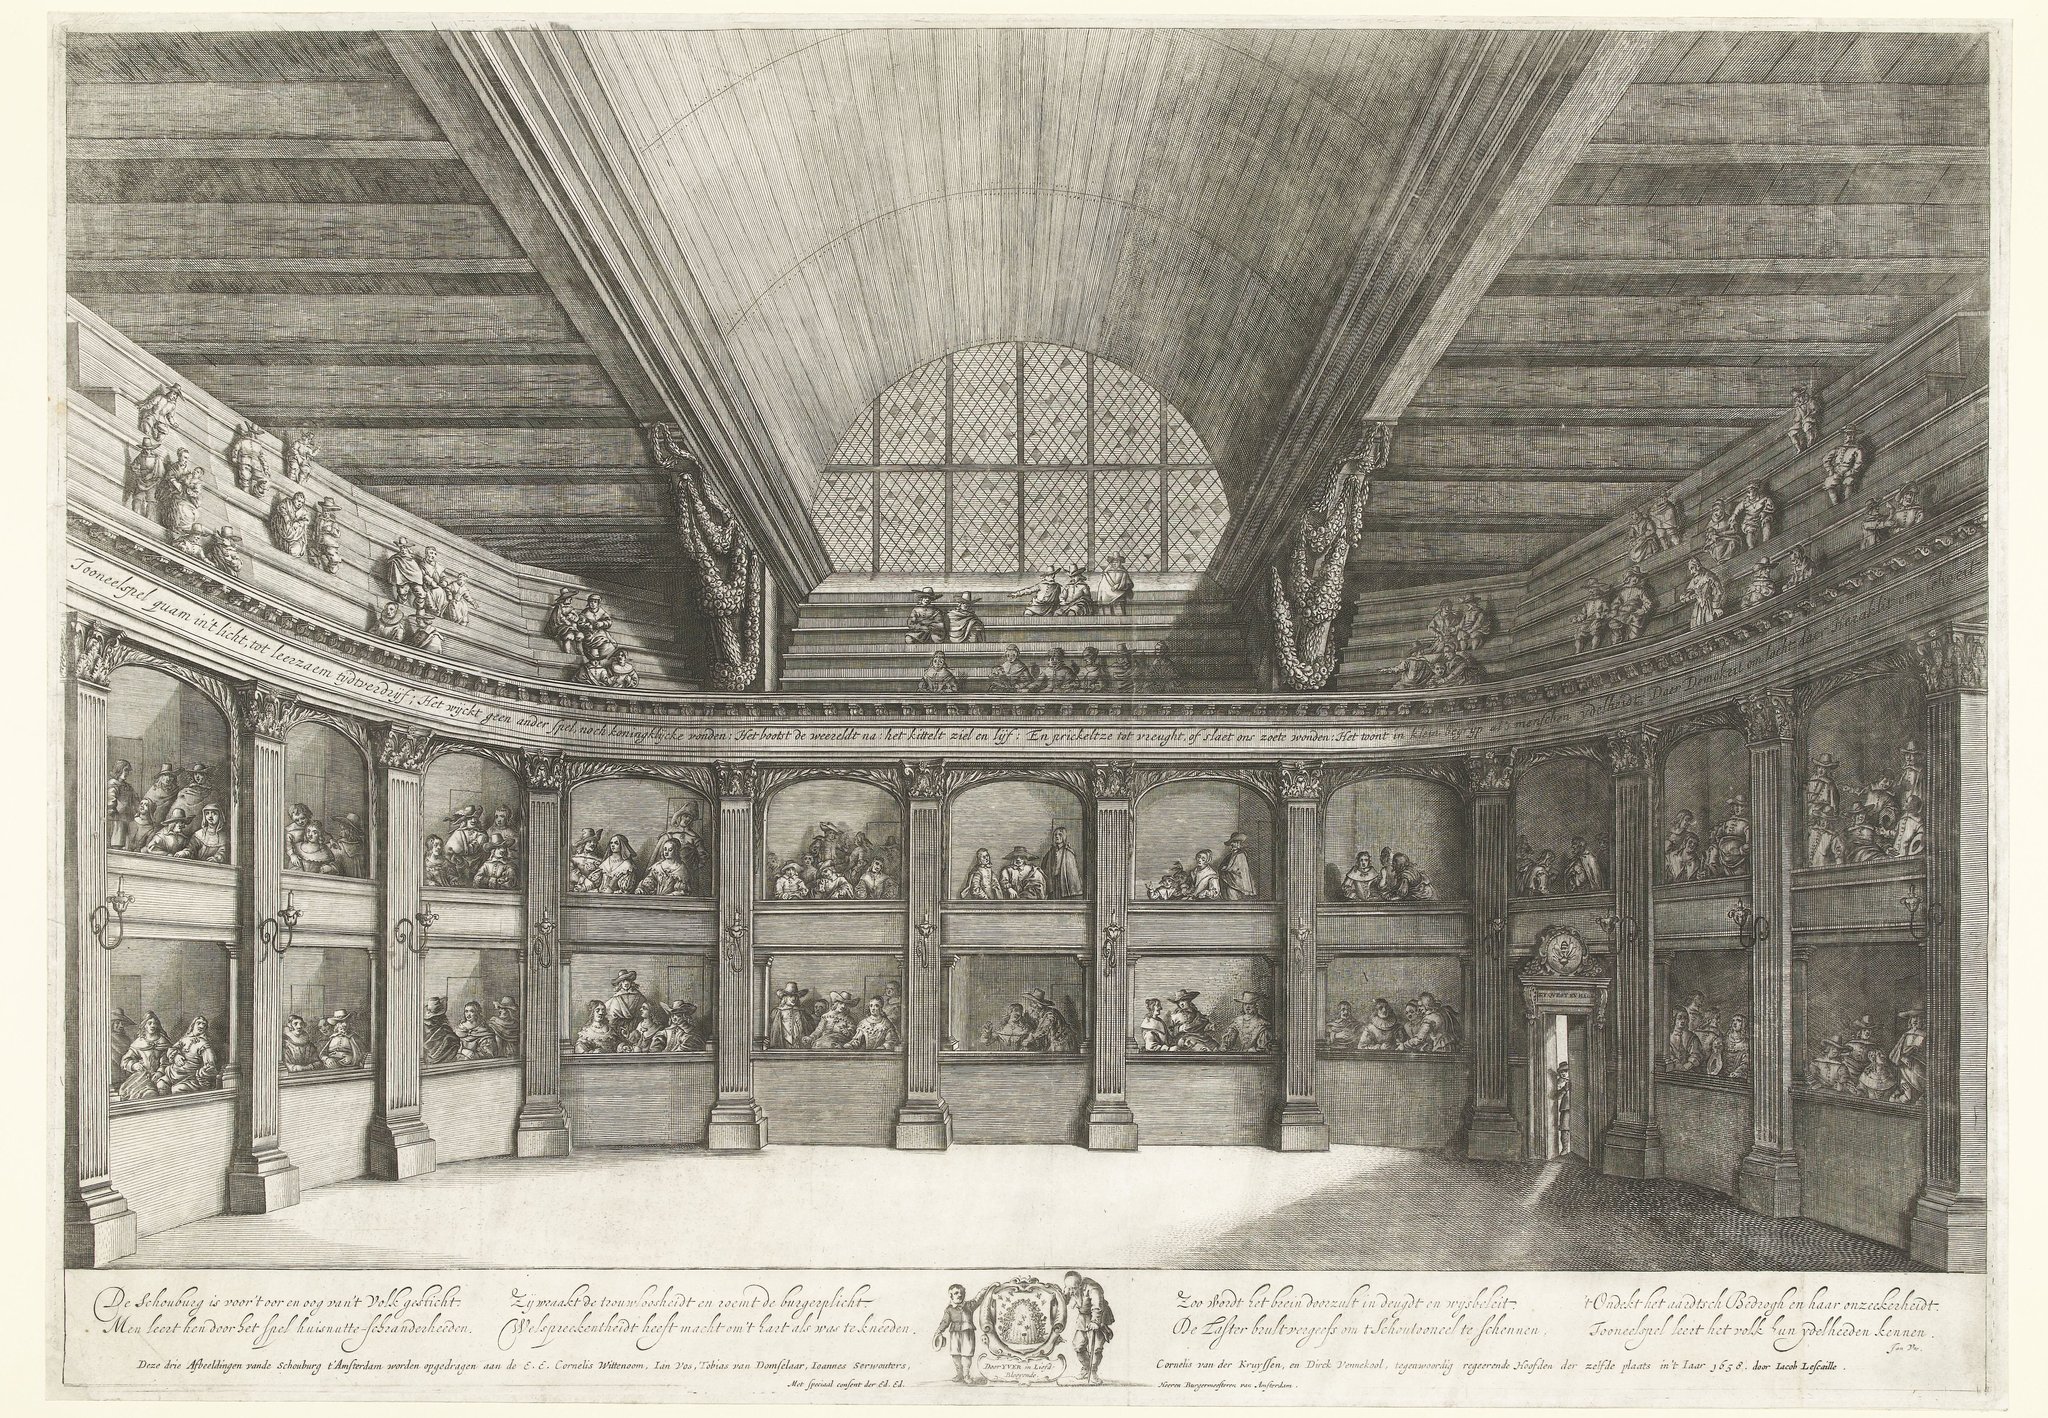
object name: print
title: De loges in de nieuwe schouwburg te Amsterdam, 1637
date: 1658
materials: paper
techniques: engraving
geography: northern netherlands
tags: the arts of the stage: ballet, theatre, musical drama, motion picture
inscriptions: collector's mark: Lugt 2228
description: Gezicht vanaf het toneel op de loges, de zitplaatsen van de nieuwe stadsschouwburg op de Keizersgracht 384 te Amsterdam, 1637. In het onderschrift 4 keer 2 regels in het Nederlands. In het midden een vignet van een jongen en een oude man aan weerszijden van een bijenkorf met het devies van de Amsterdamse Schouwburg: Door Yver in Liefde Bloeyende.